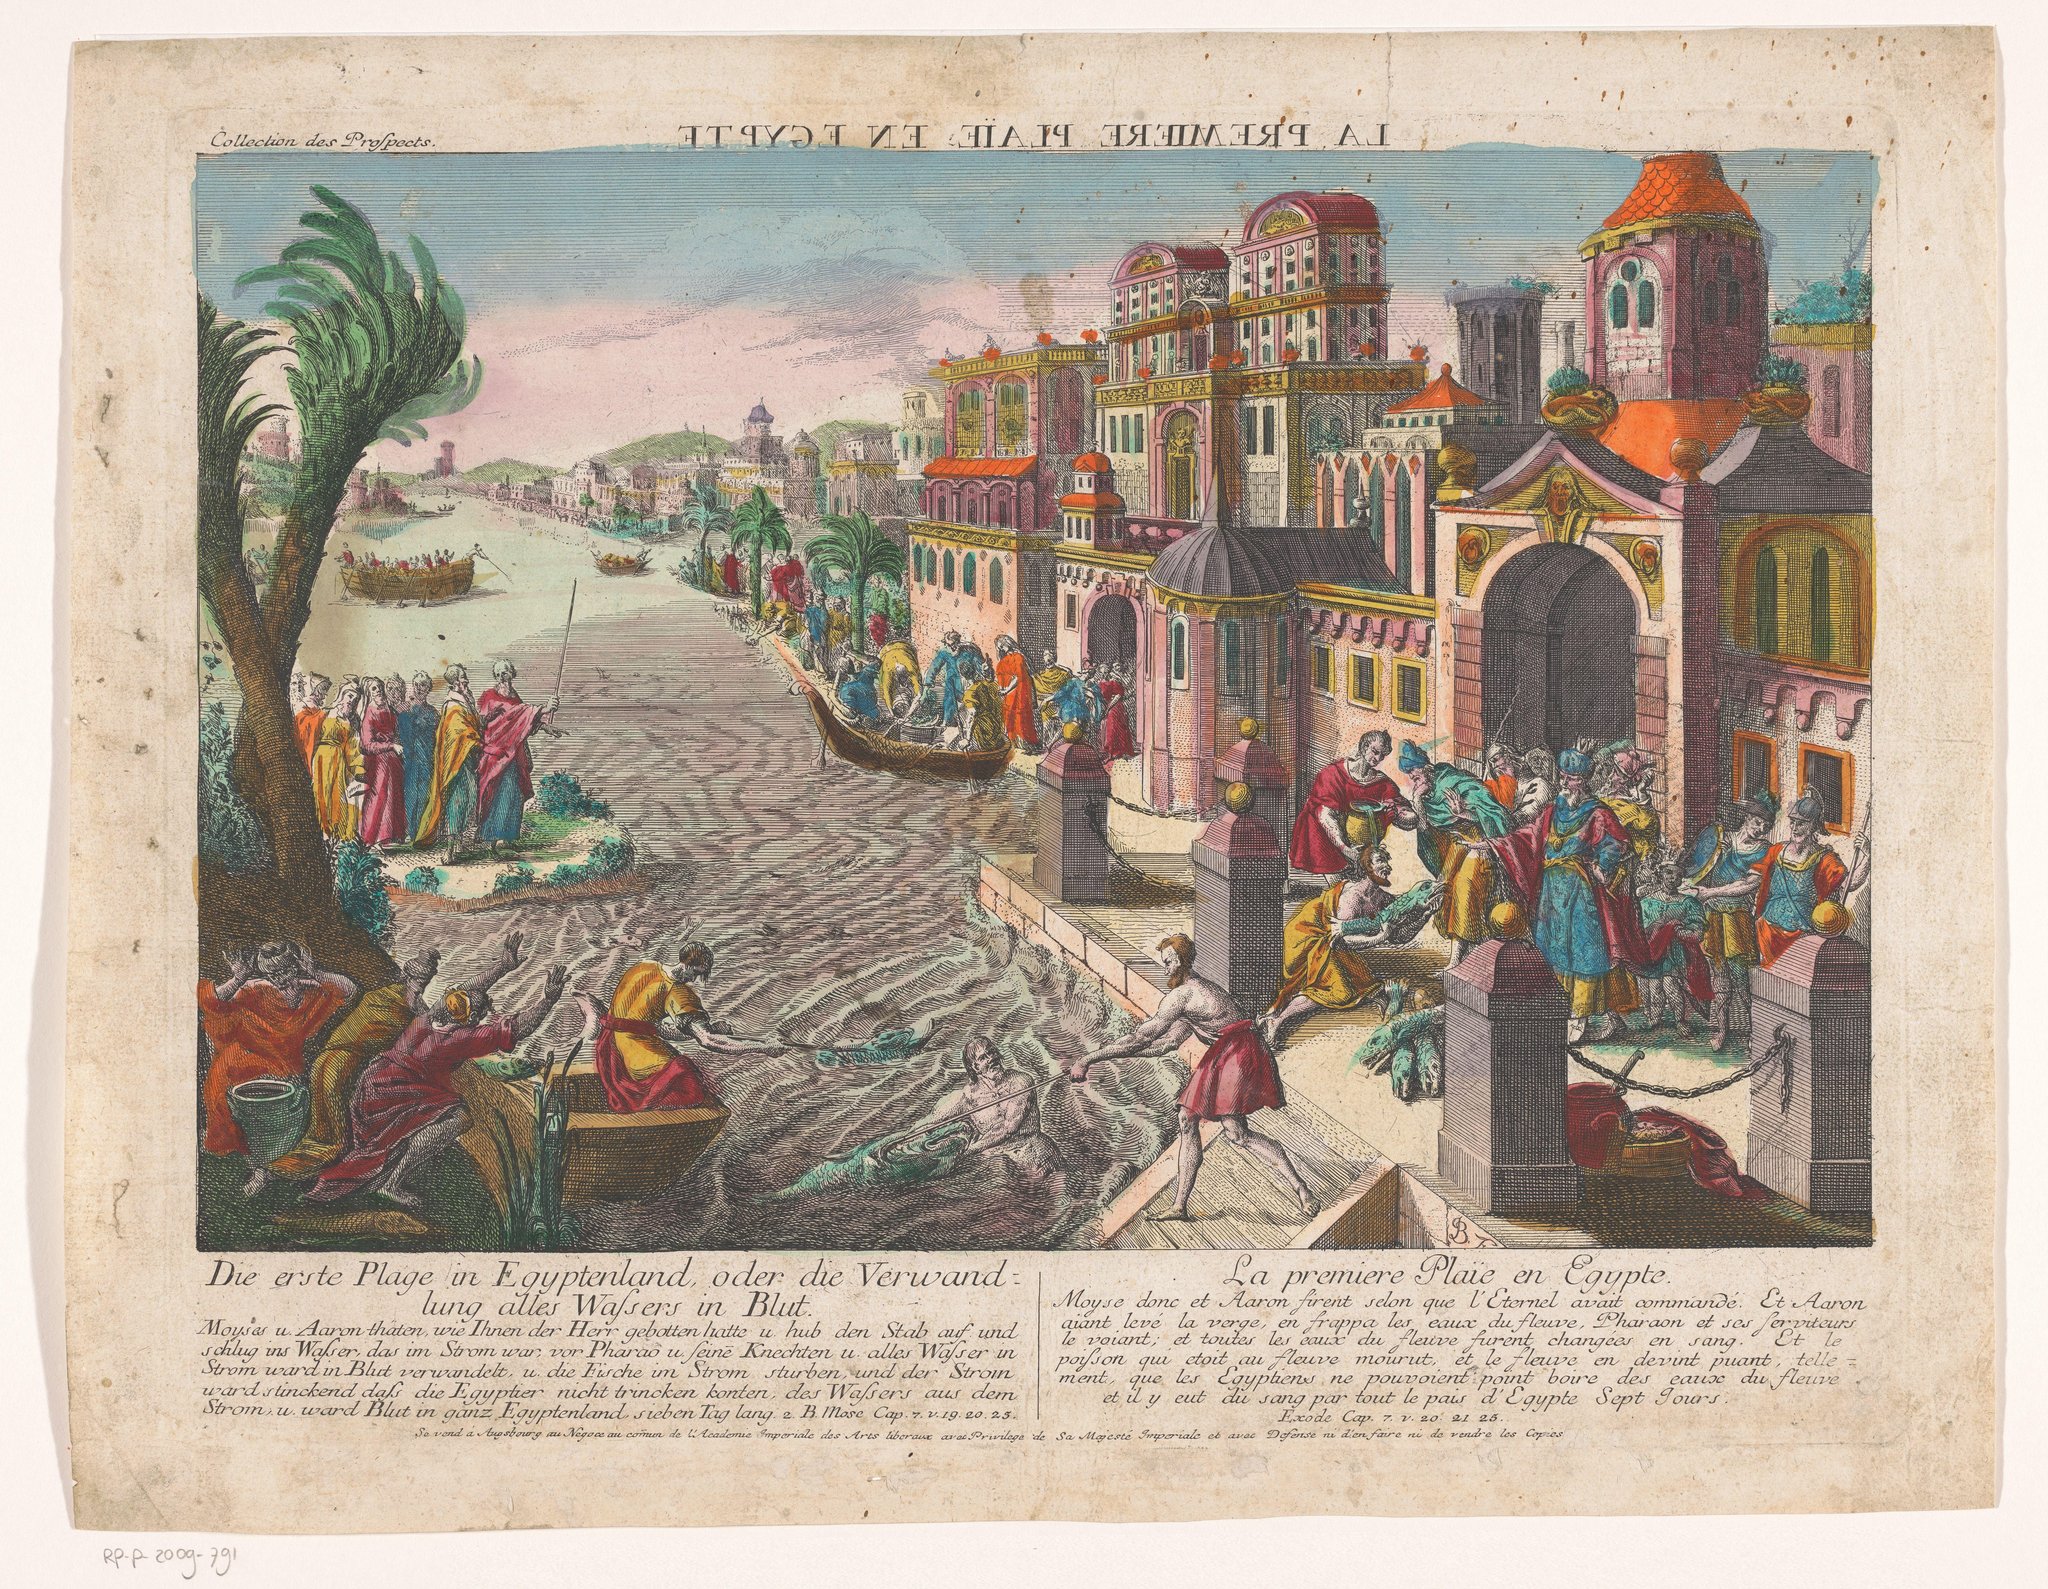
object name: print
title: Die erste Plage in Egyptenland (...)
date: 1755-1779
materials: paper, watercolor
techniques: brush, etching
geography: germany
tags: the plague of water turned into blood: as pharaoh goes down to the nile, aaron strikes the surface of the river with his rod; the water turns into blood and all the fishes die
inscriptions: collector's mark: Lugt 2228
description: De plaag van het in bloed veranderde water. Gezicht op een stad aan een rivier. Op de oever links Mozes die met zijn stok op het water slaat. Rechts op de kade de Farao met zijn gevolg. Het water is rood gekleurd en er worden dode vissen uitgehaald. Onder prent uitleg in Duits en Frans.